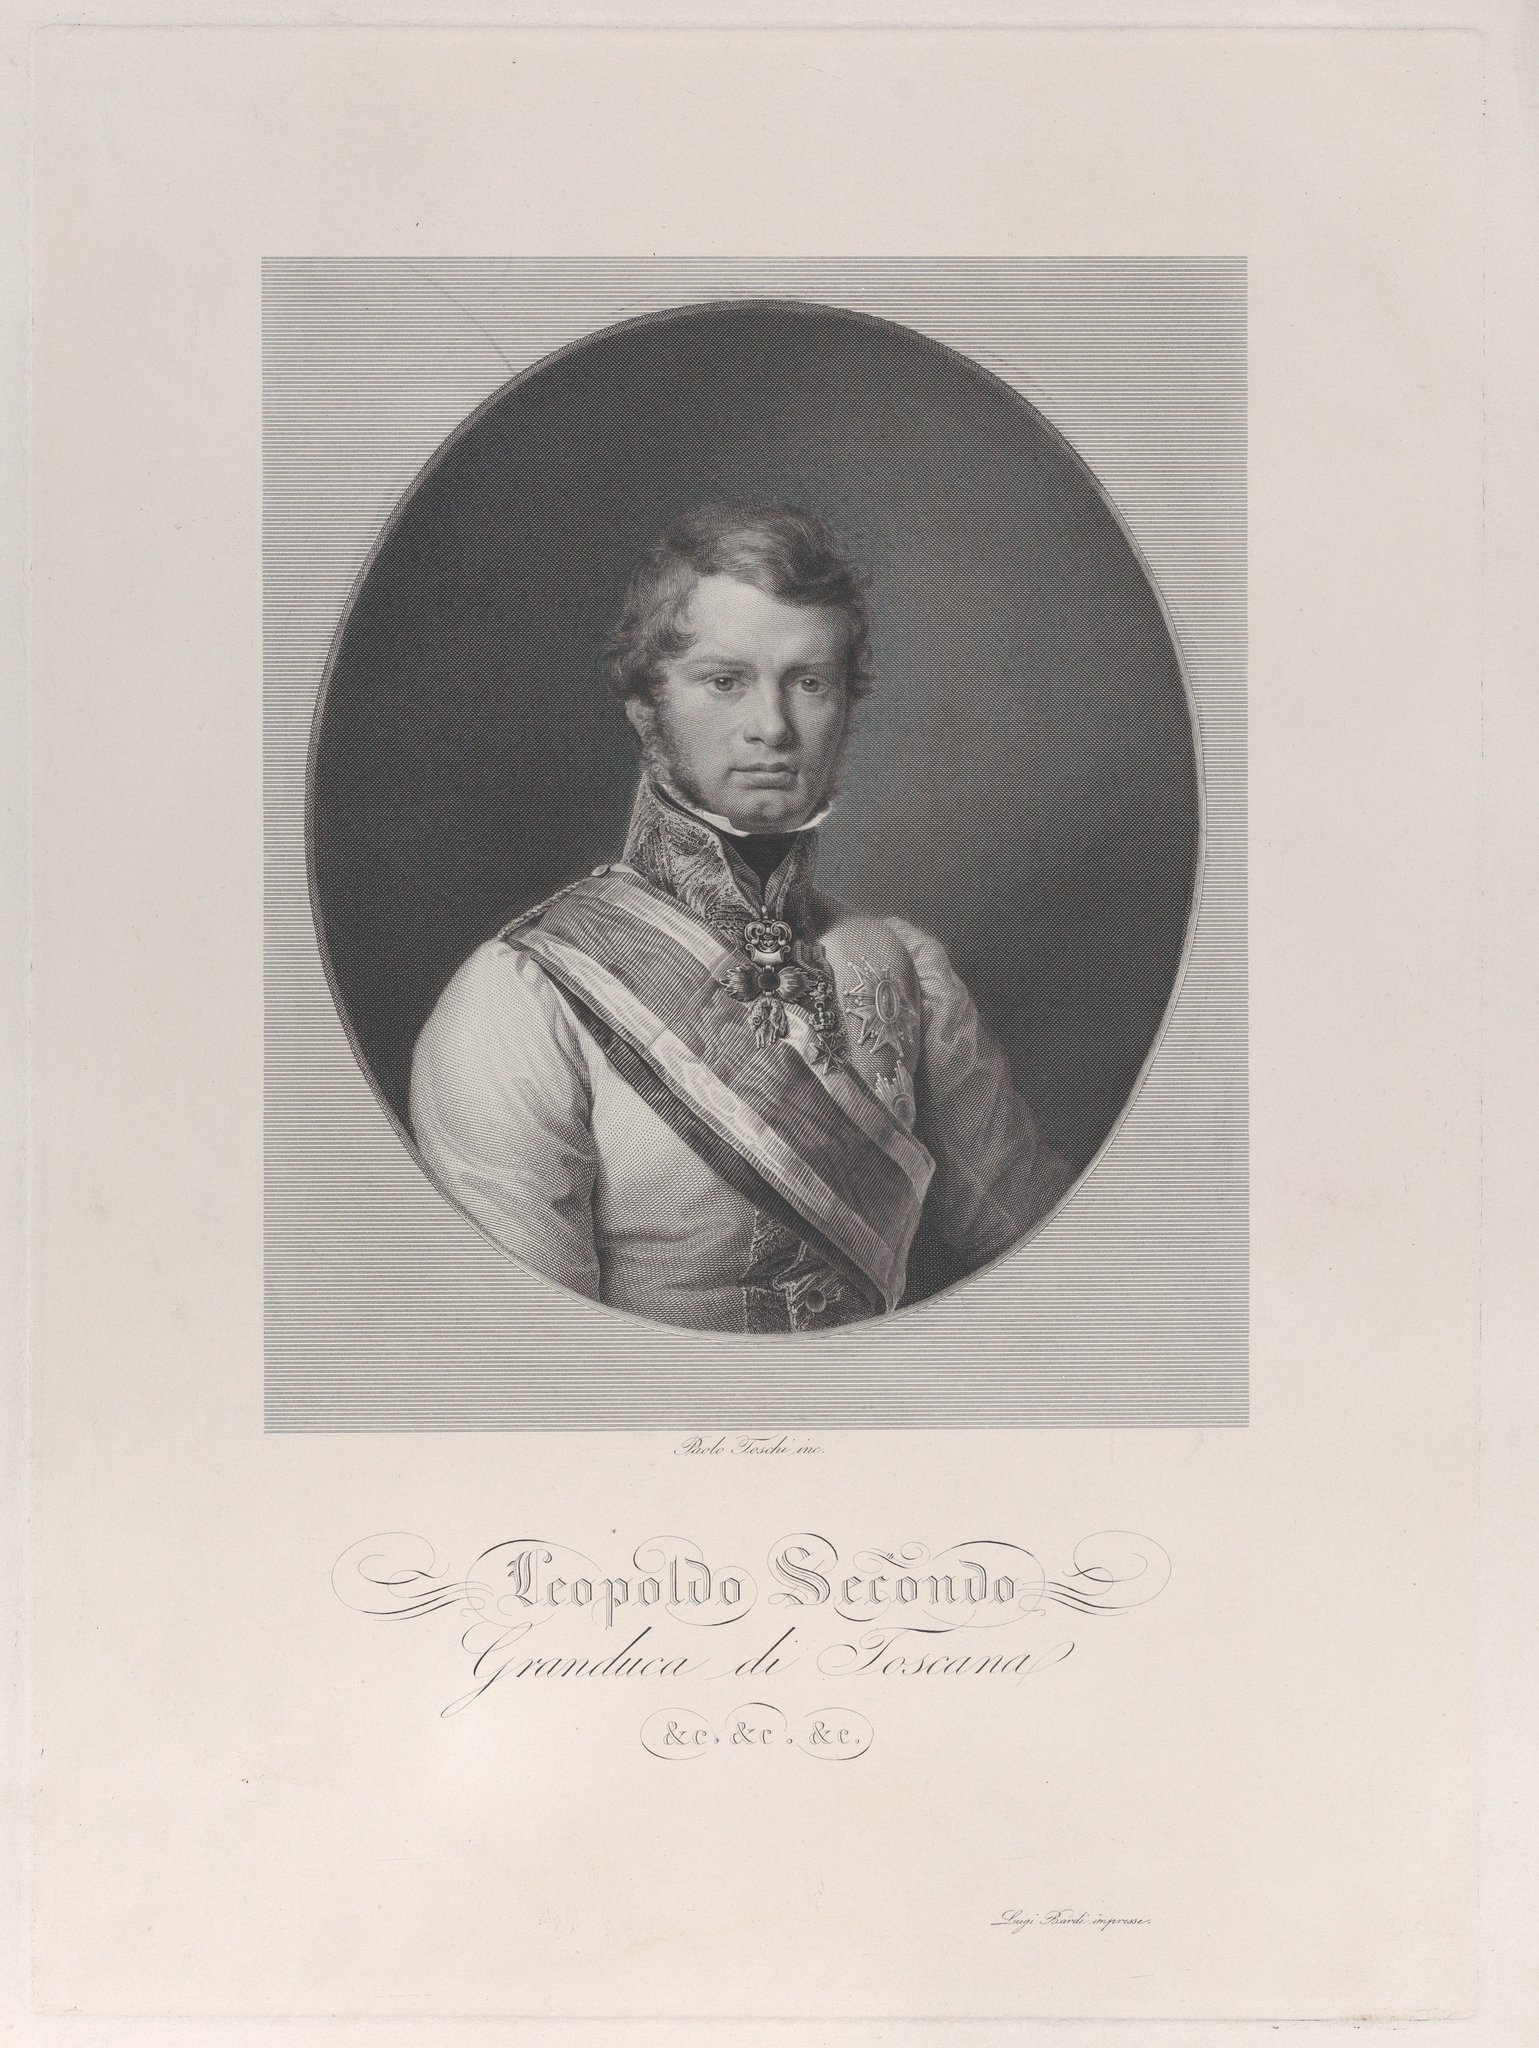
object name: print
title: Oval portrait of Leopold II, Grand Duke of Tuscany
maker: paolo toschi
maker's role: artist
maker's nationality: italian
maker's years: 1788-1854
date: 1833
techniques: engraving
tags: men,portraits